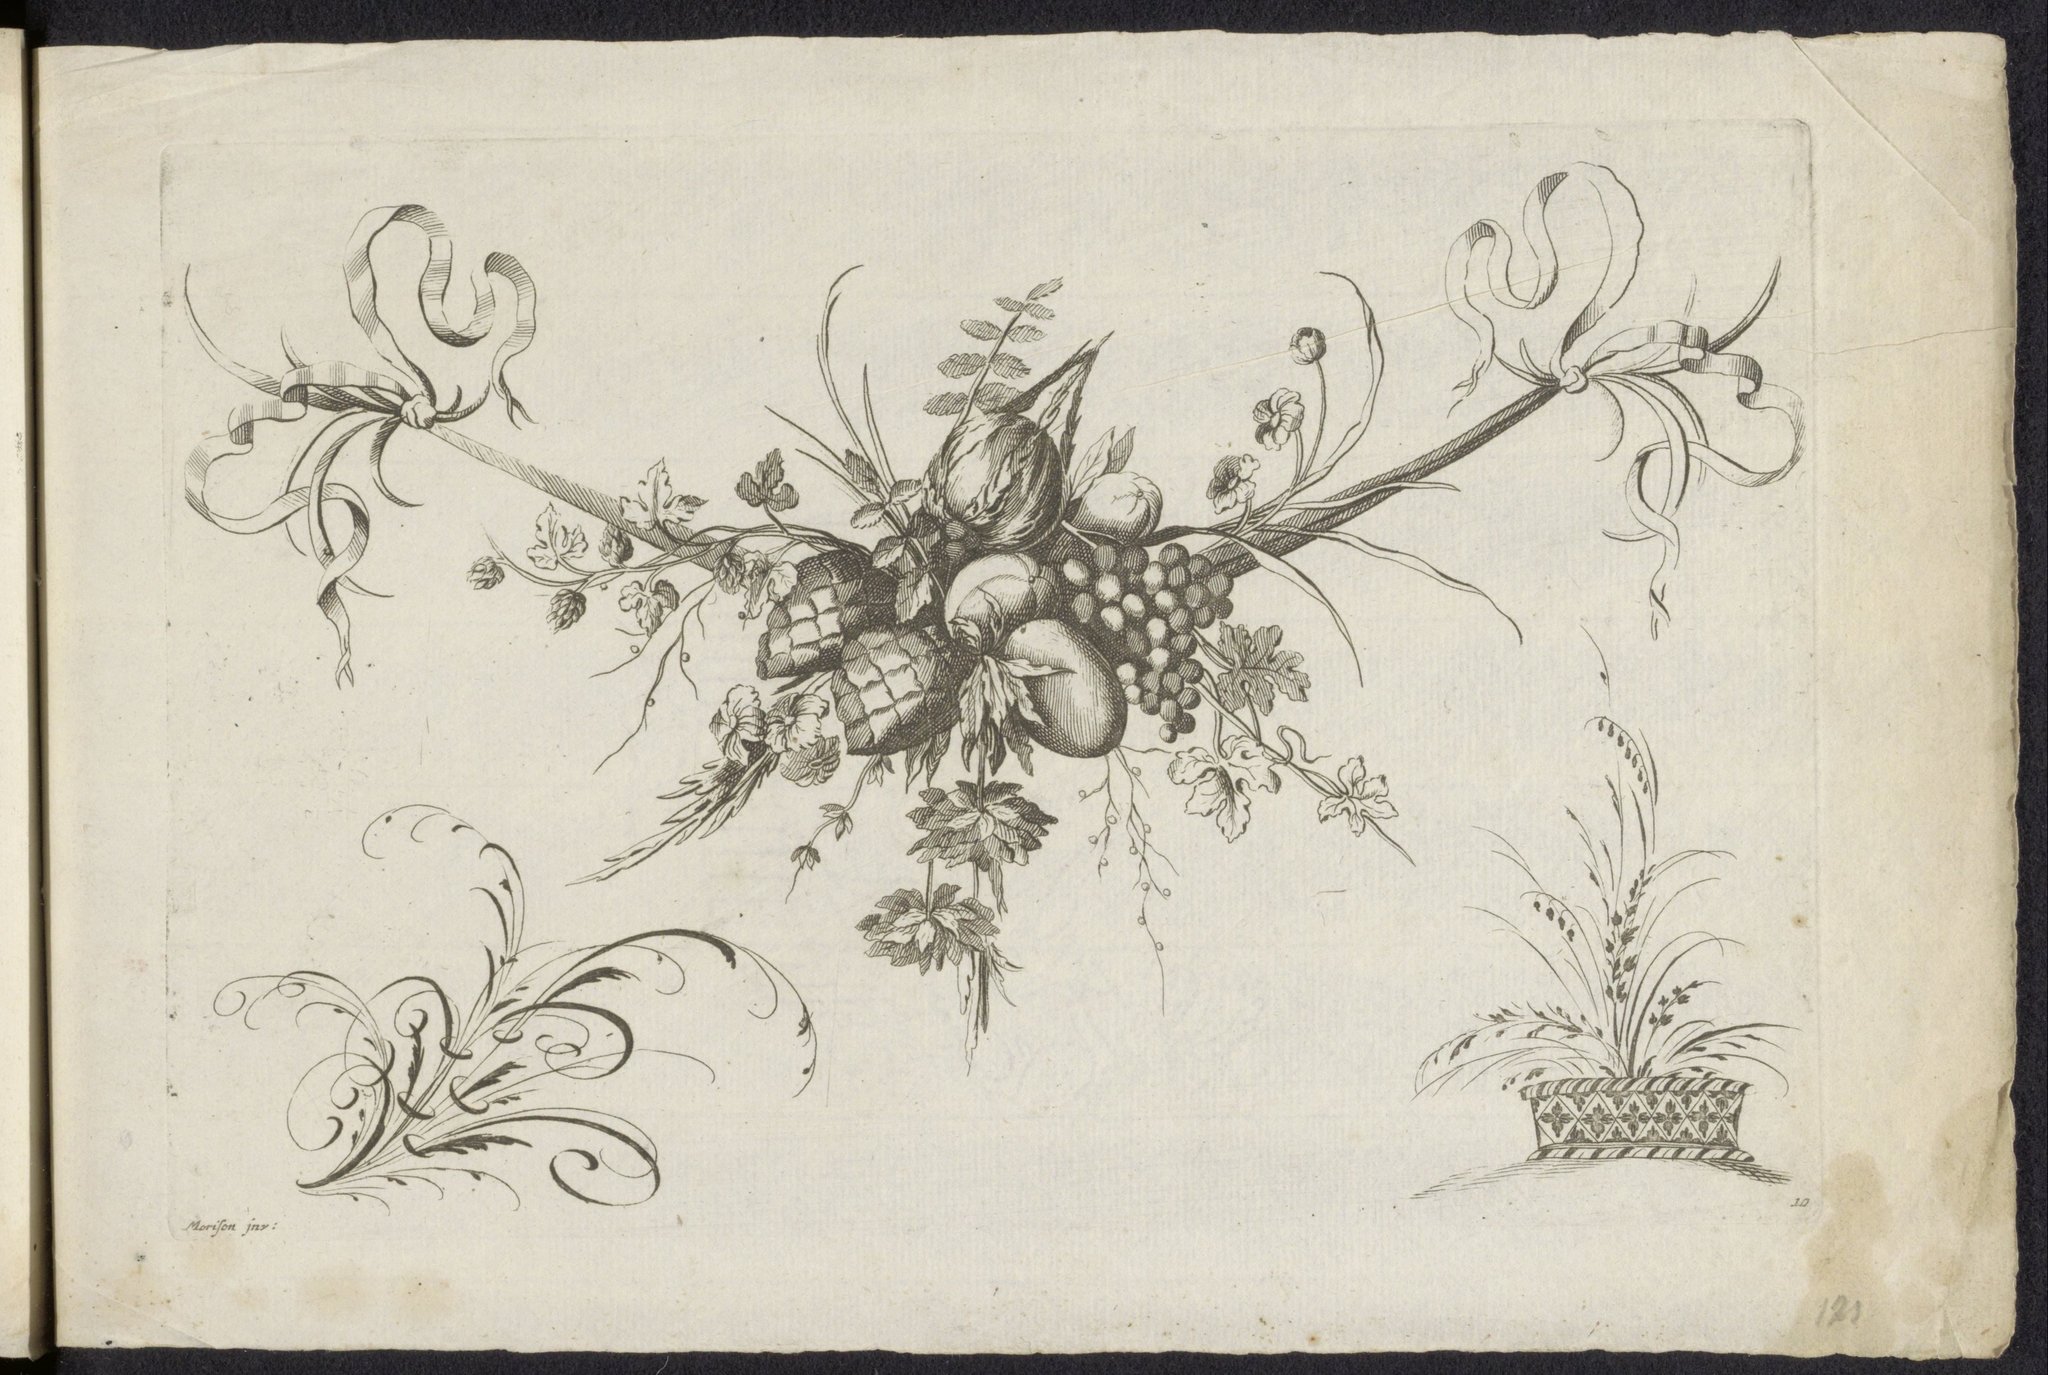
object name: ornament print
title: Festoen van vruchten, bladeren en bloemen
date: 1699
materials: paper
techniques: etching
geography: germany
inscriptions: inscription: ‘r.o.: No 10’, signature and date: ‘l.o.: Morison inv.’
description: Het festoen hangt aan een lint. Linksonder zijn gestileerde zwarte ranken te zien, rechtsonder gestileerde zwarte bladranken in een mand.